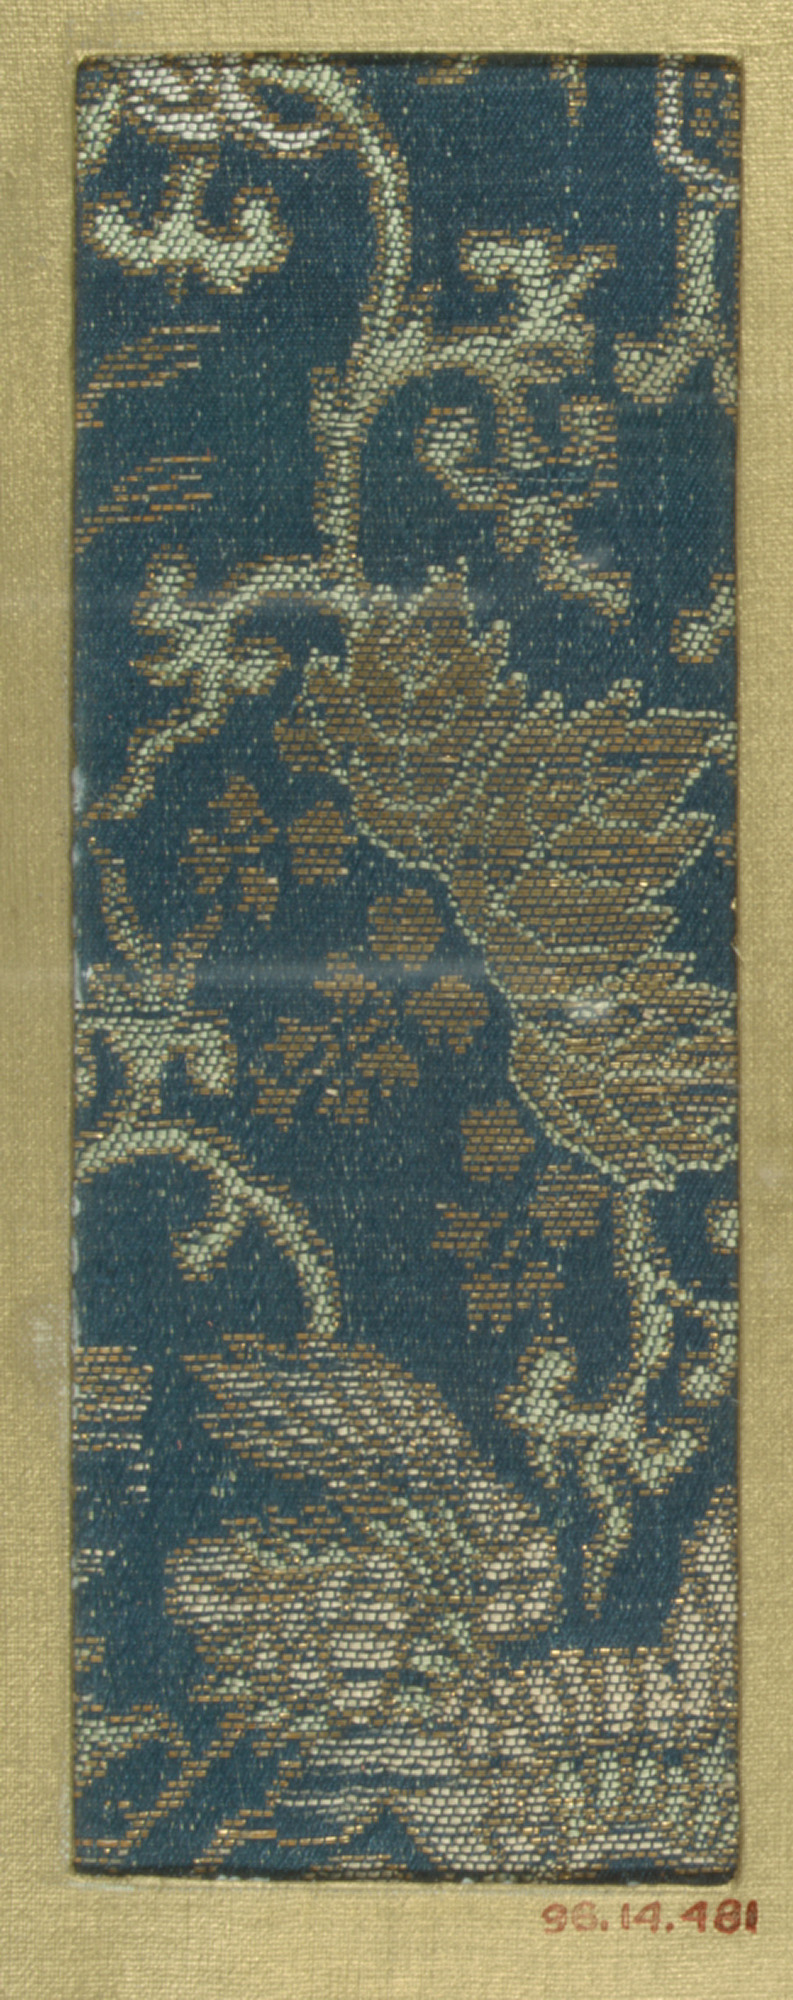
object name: fragment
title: Textile fragment with incomplete pattern of paulownia and part of a bird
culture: japanese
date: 1701-1900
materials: silk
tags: plants